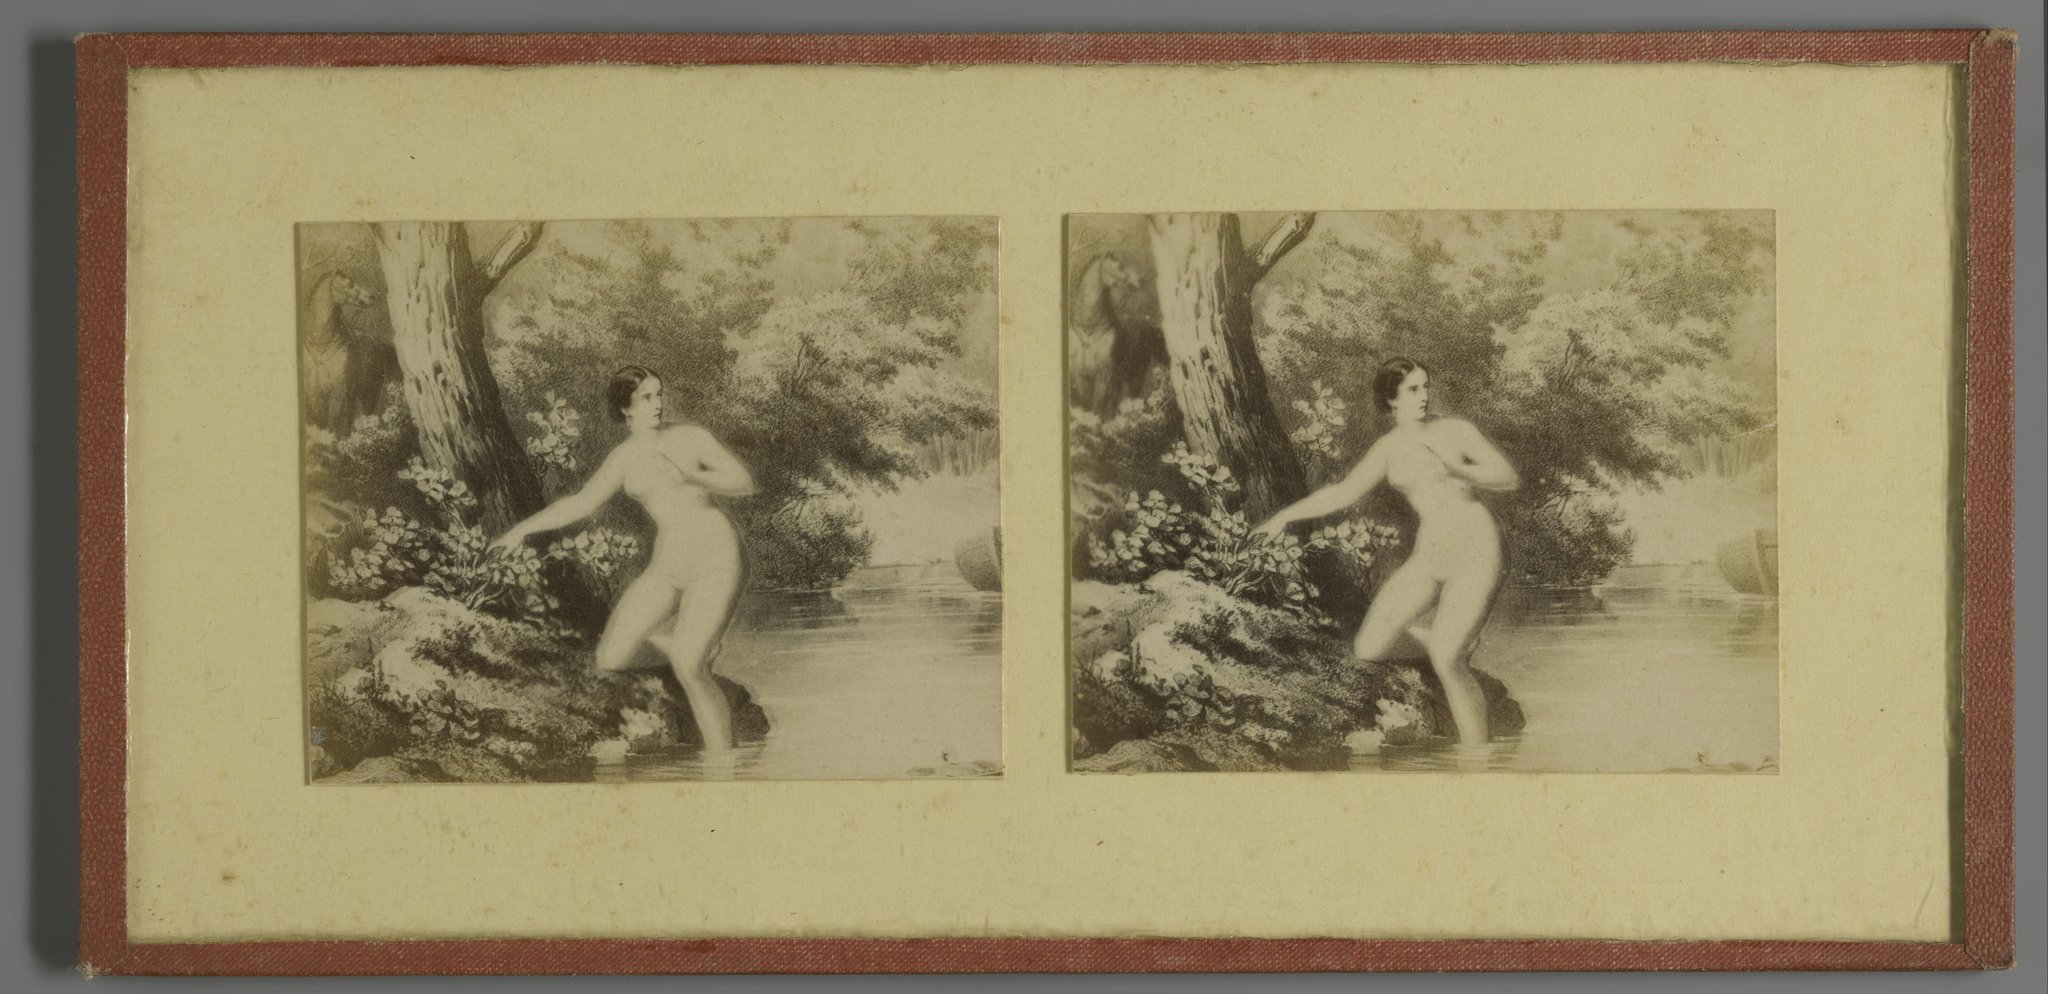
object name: reproduction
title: Fotoreproductie van een prent van een naakte vrouw aan de oever in het bos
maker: Anonymous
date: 1885-1920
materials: cardboard, glass, paper, photographic support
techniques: albumen print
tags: river bank, woman (showing herself) undressed, quasi-nude, forest, wood